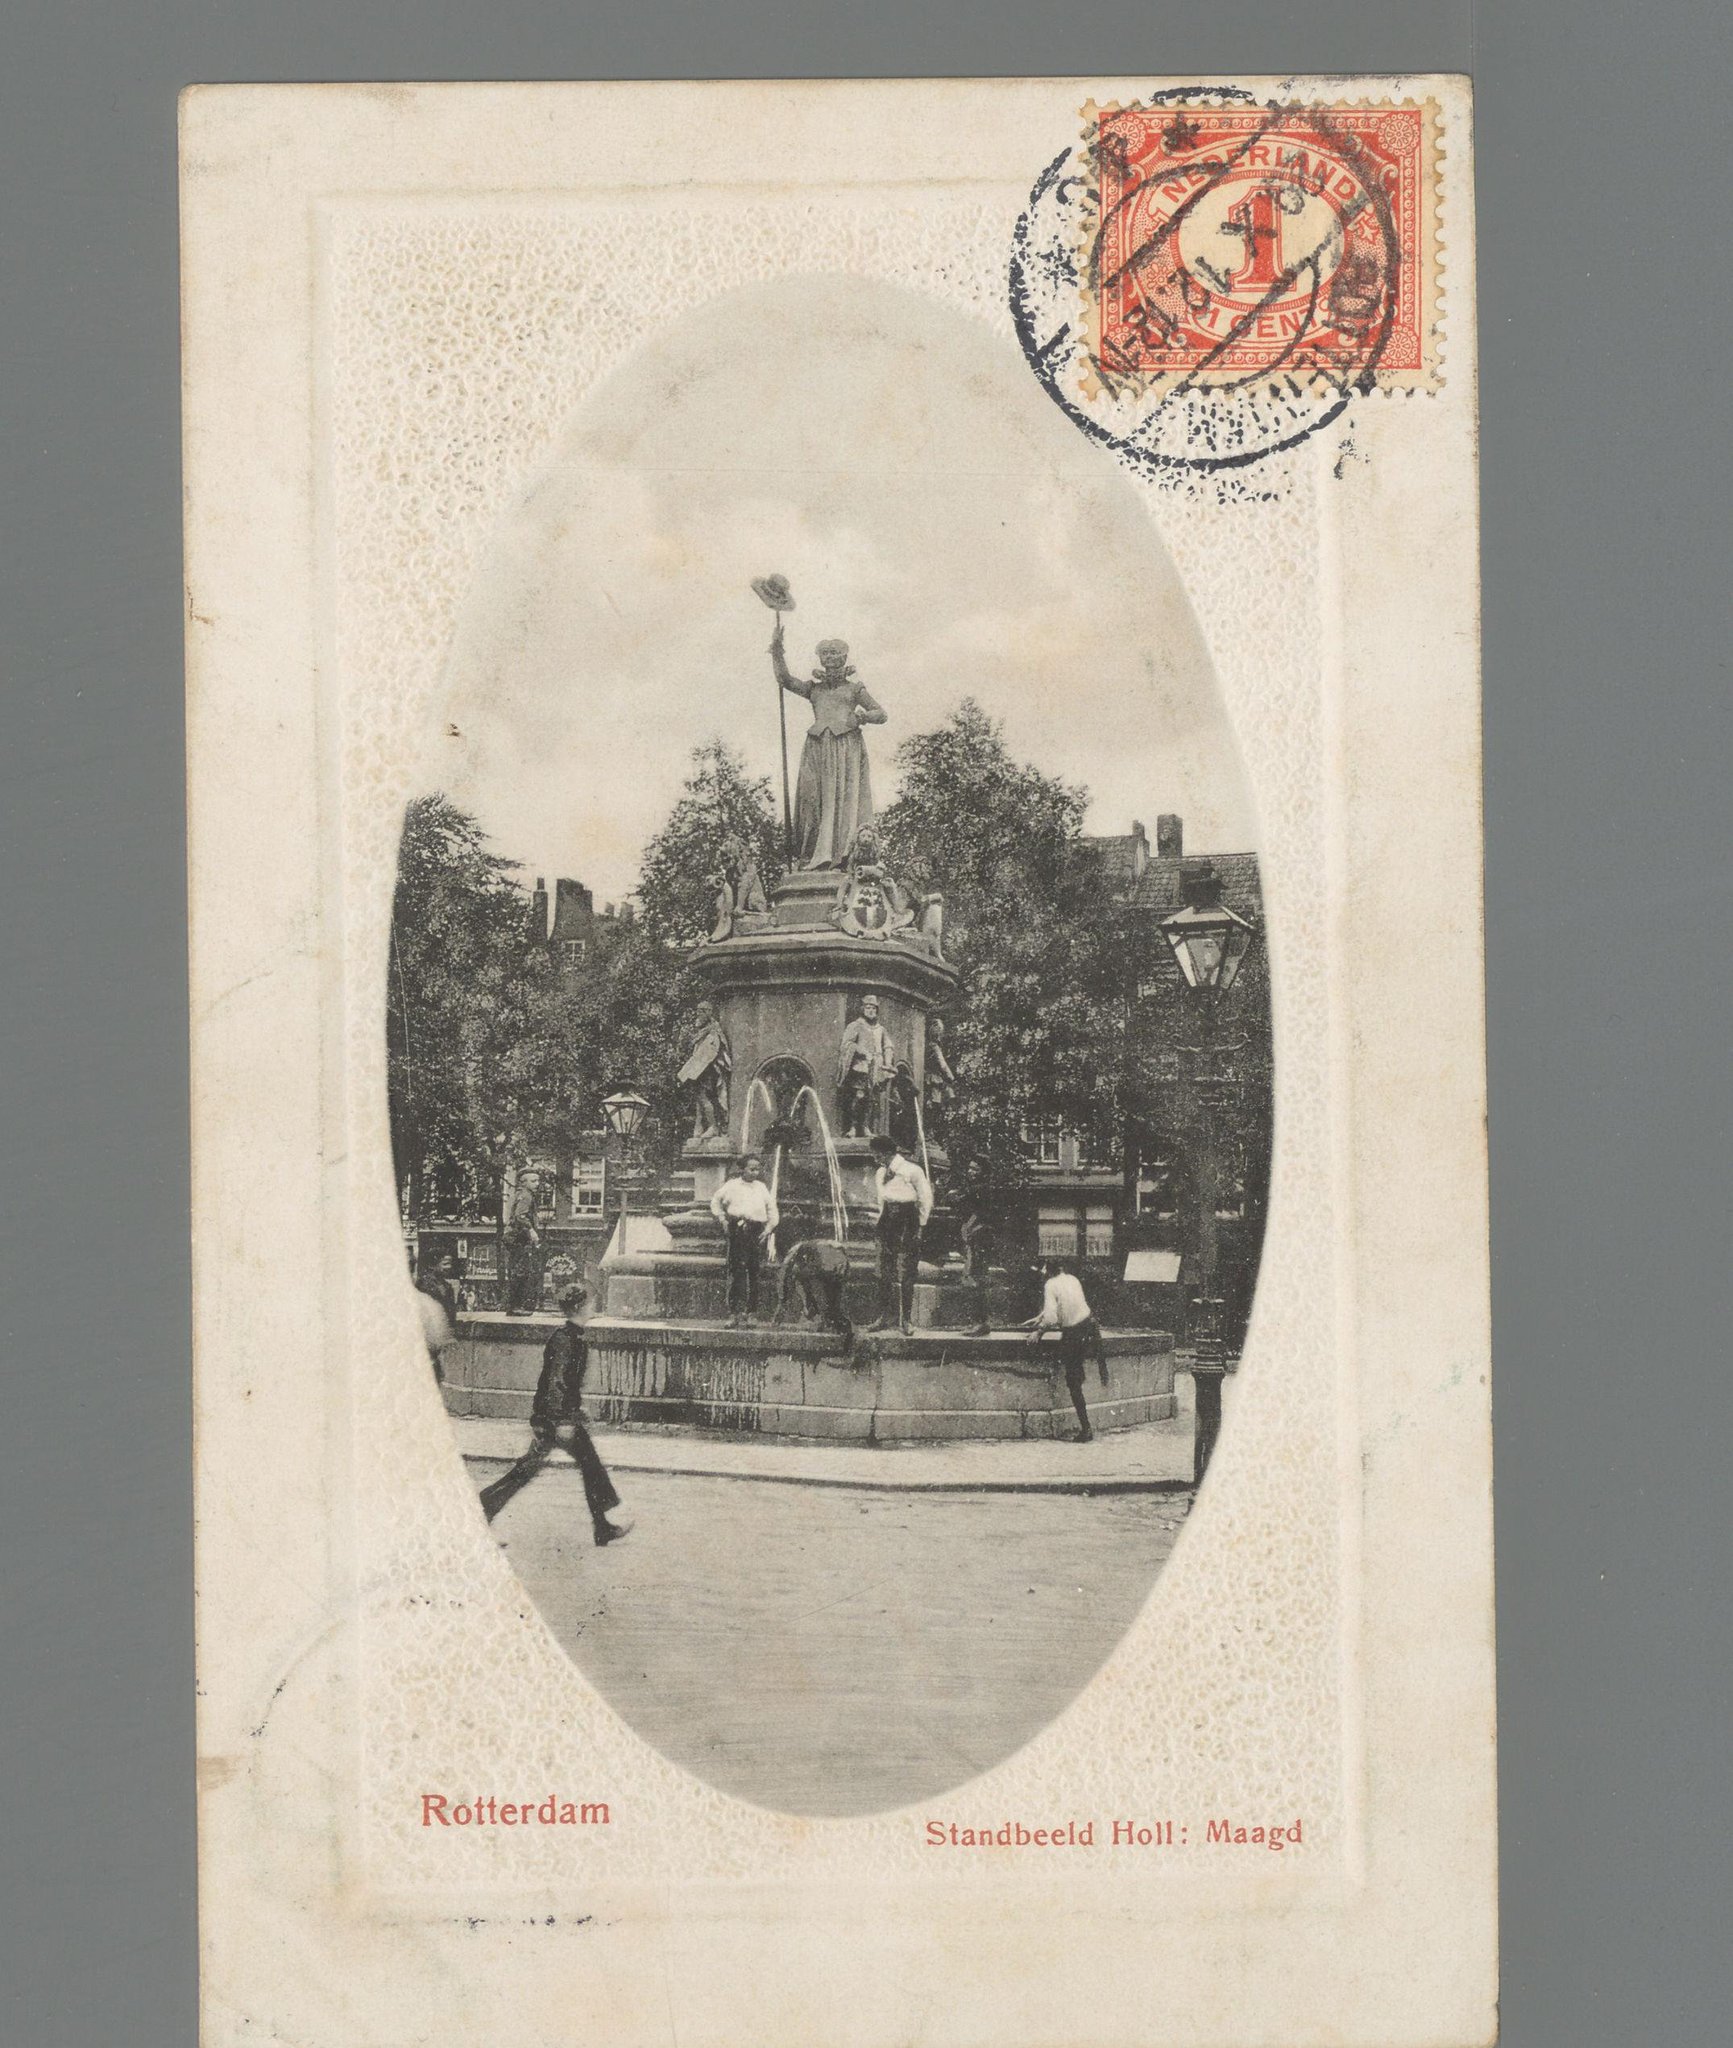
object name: ansichtkaart, prentbriefkaart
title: Rotterdam. Standbeeld Holl: Maagd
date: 1905-1912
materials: cardboard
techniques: photograph, writing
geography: amsterdam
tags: monument, statue, rotterdam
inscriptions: postage stamp